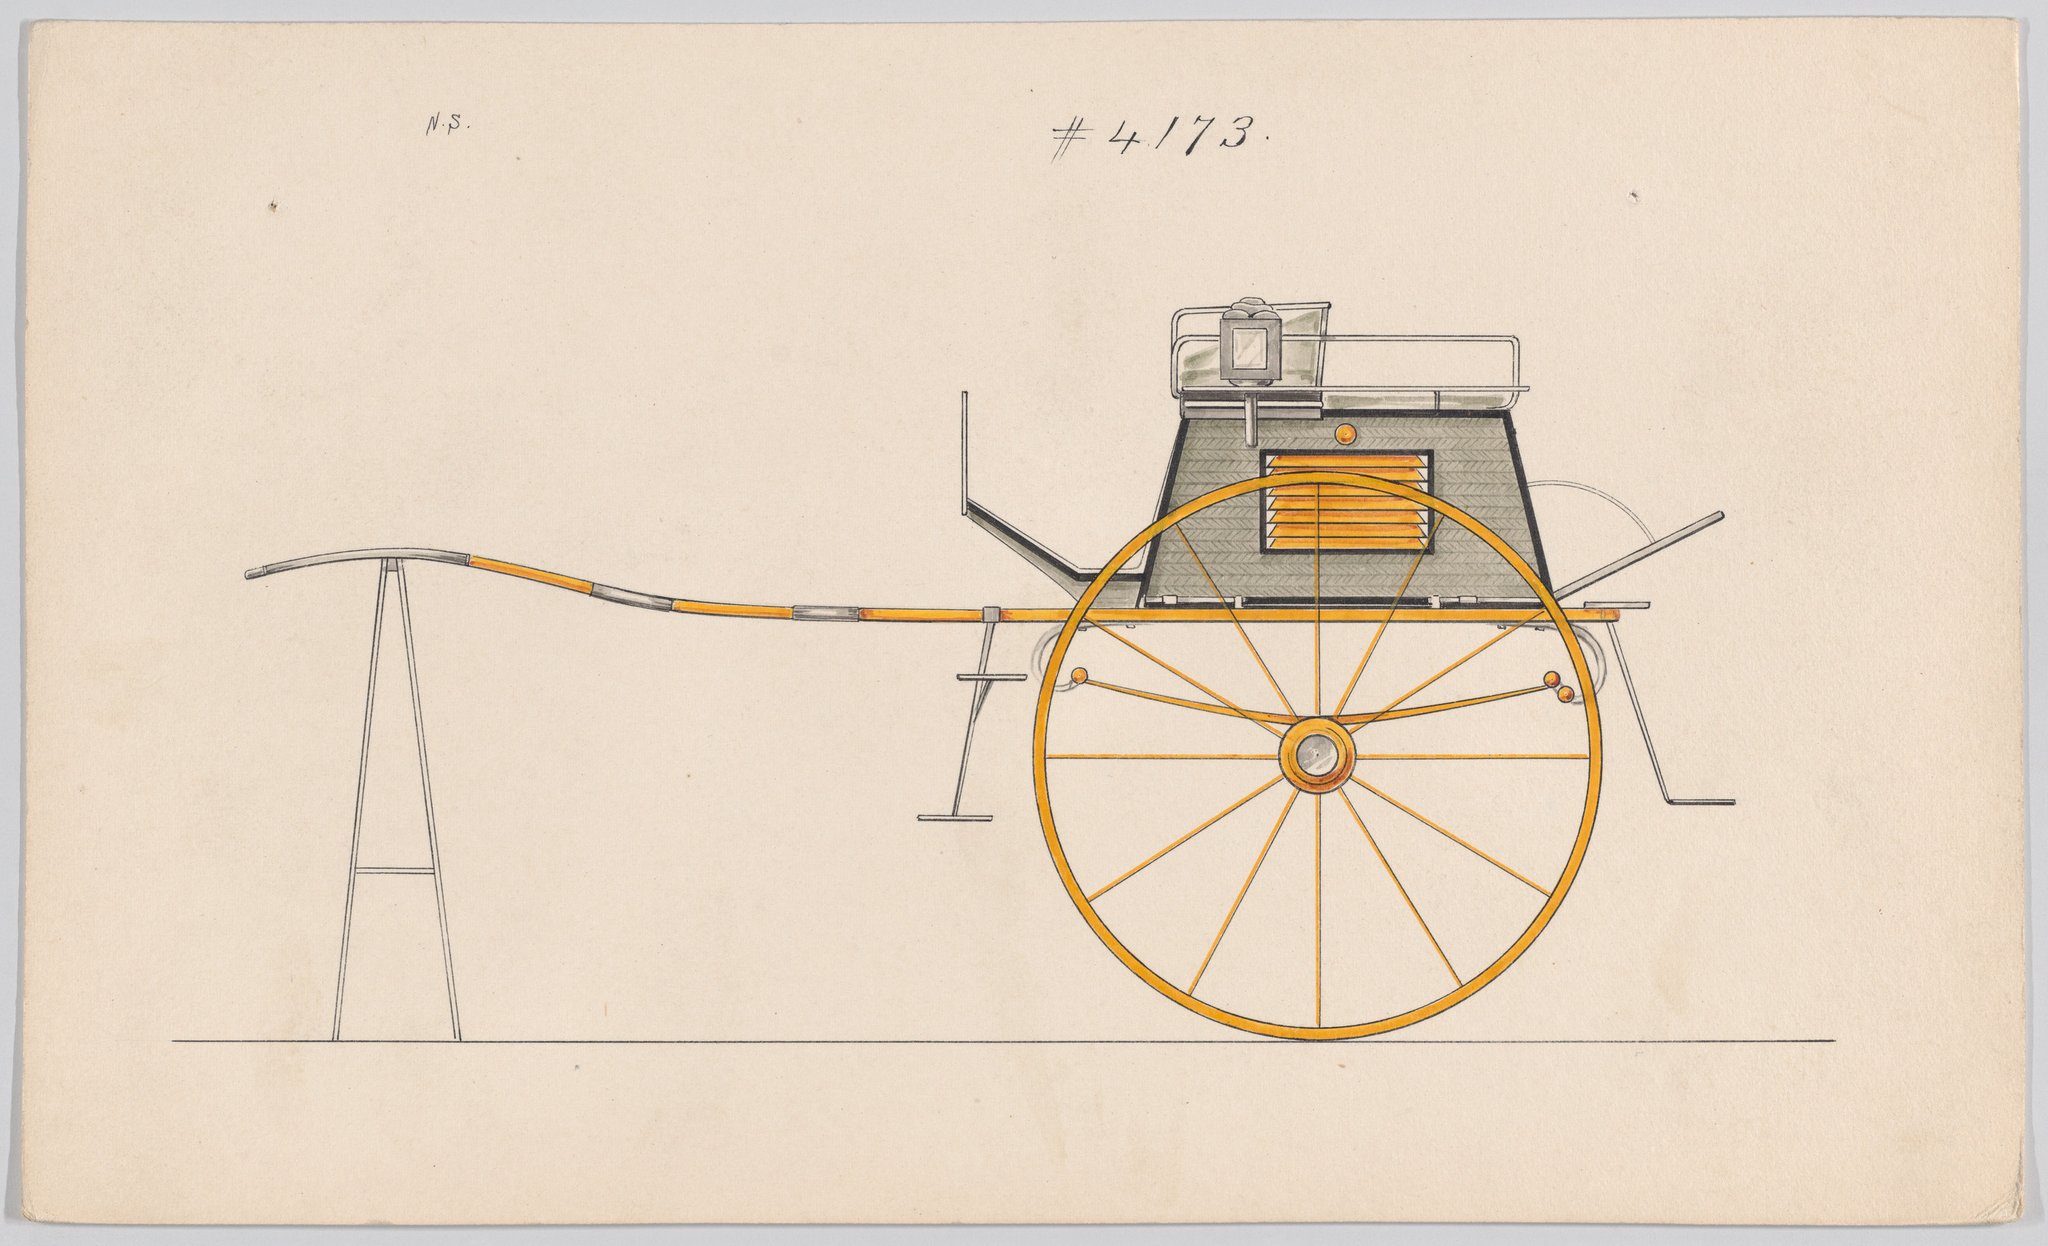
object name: drawing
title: Design for Dog Cart or 2 Wheeler, no. 4173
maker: brewster & co.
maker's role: manufacturer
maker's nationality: american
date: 1892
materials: gouache, ink, watercolor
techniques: pen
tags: carriages